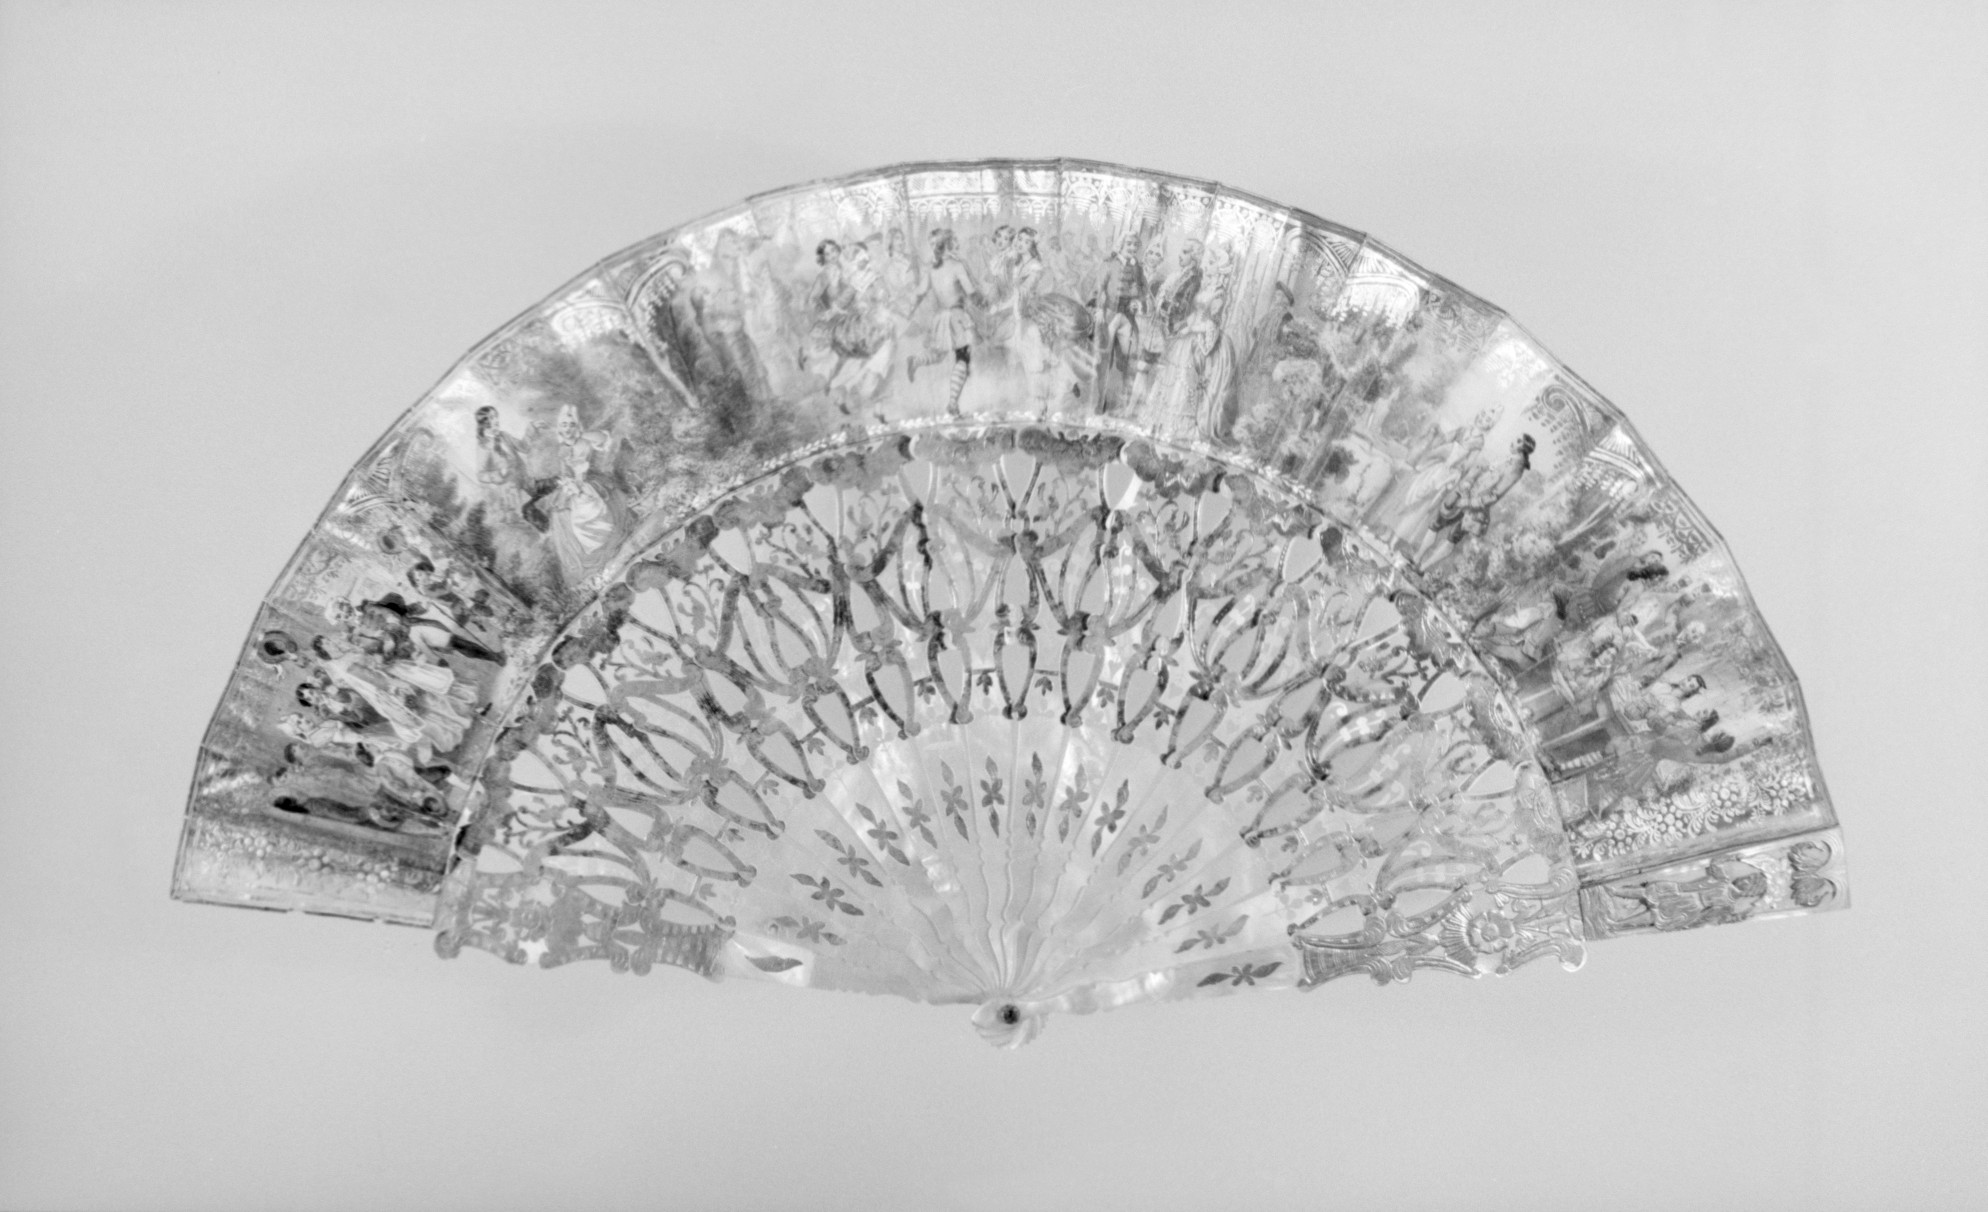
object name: fan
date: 1840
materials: gilt, glass, mother of pearl, paint, paper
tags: men,women,dancing